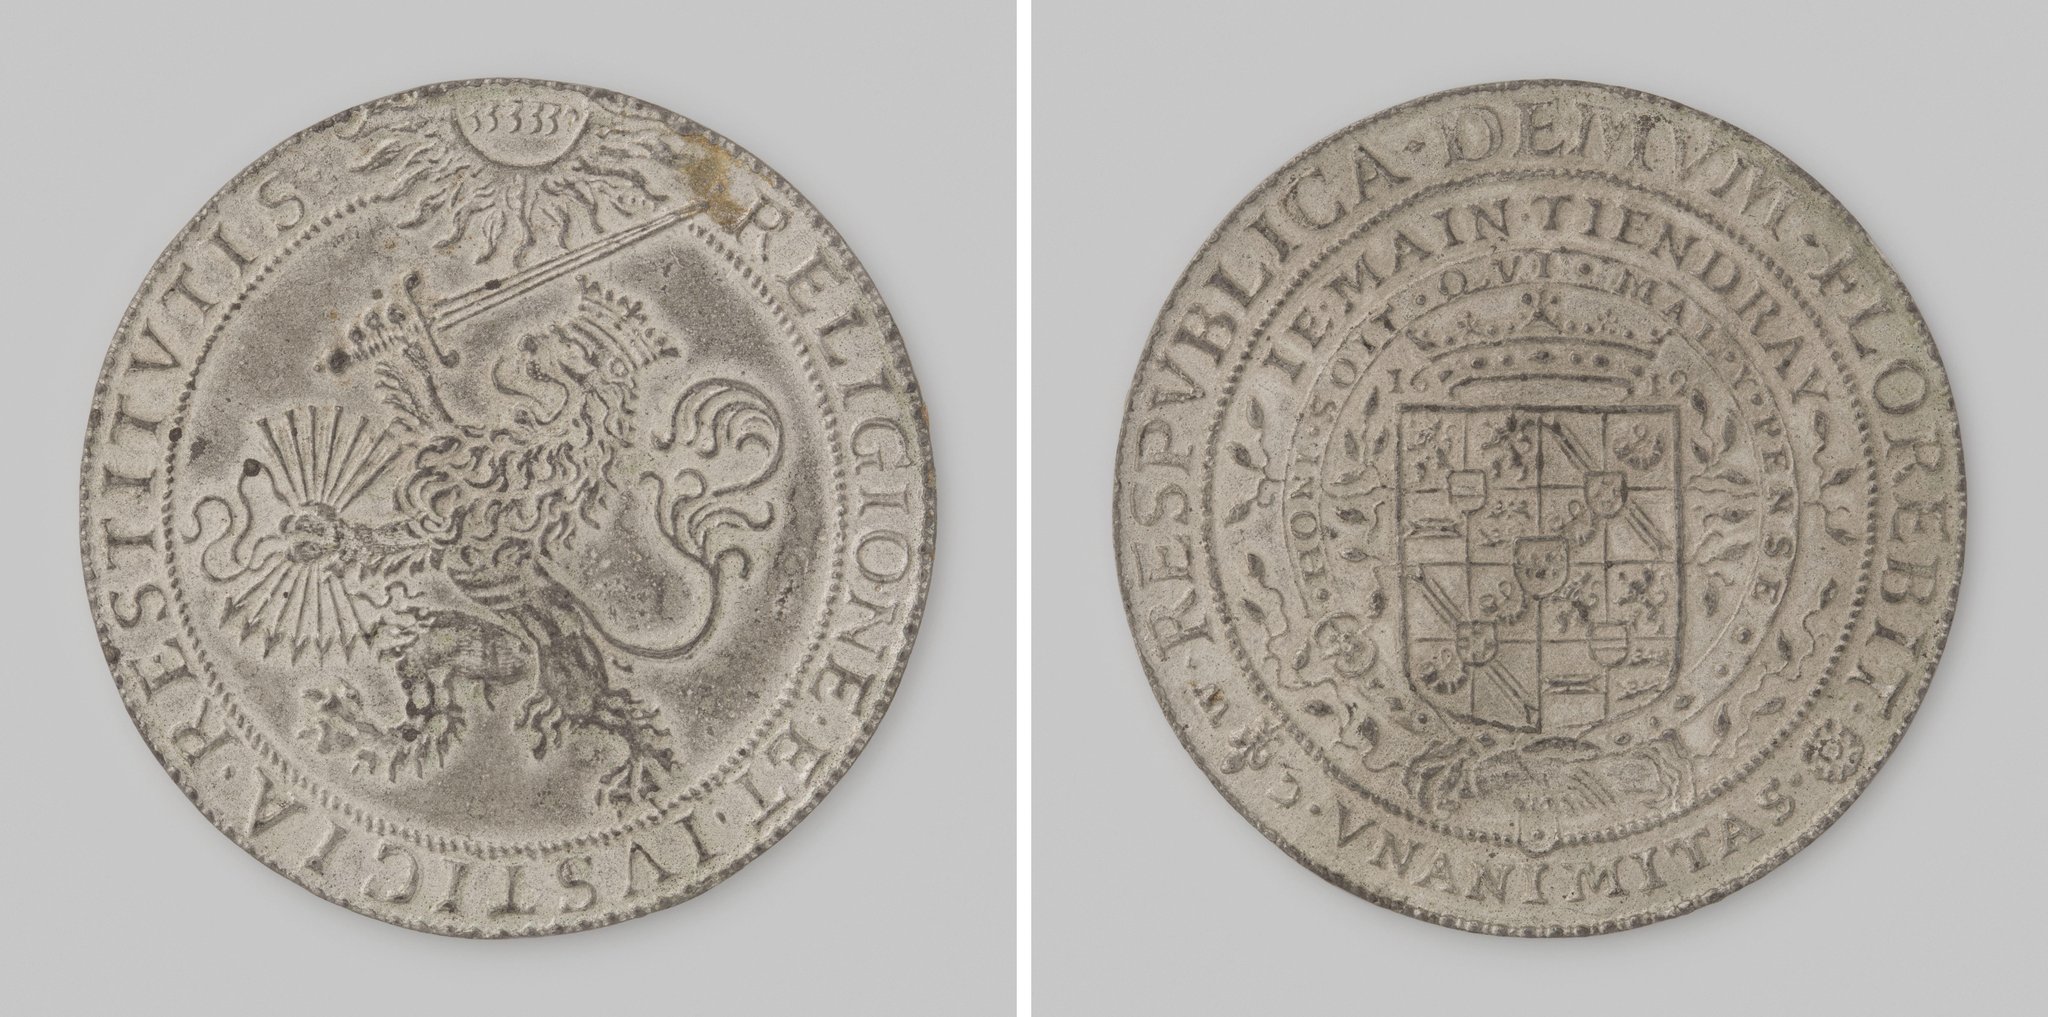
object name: history medal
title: Herstel van de staatkundige en kerkelijke rust door Prins Maurits 1619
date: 1619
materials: tin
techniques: casting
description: Tinnen penning, op de voorzijde een gekroonde klimmende leeuw naar links met zwaard en pijlenbundel onder de vlammende naam Gods, met omschrift, op de keerzijde een gekroond wapenschild omhangen met de kousenband tussen bladranken, binnen een rand met bovenaan omschrift en onderaan twee ineengedrukte handen, met omschrift.